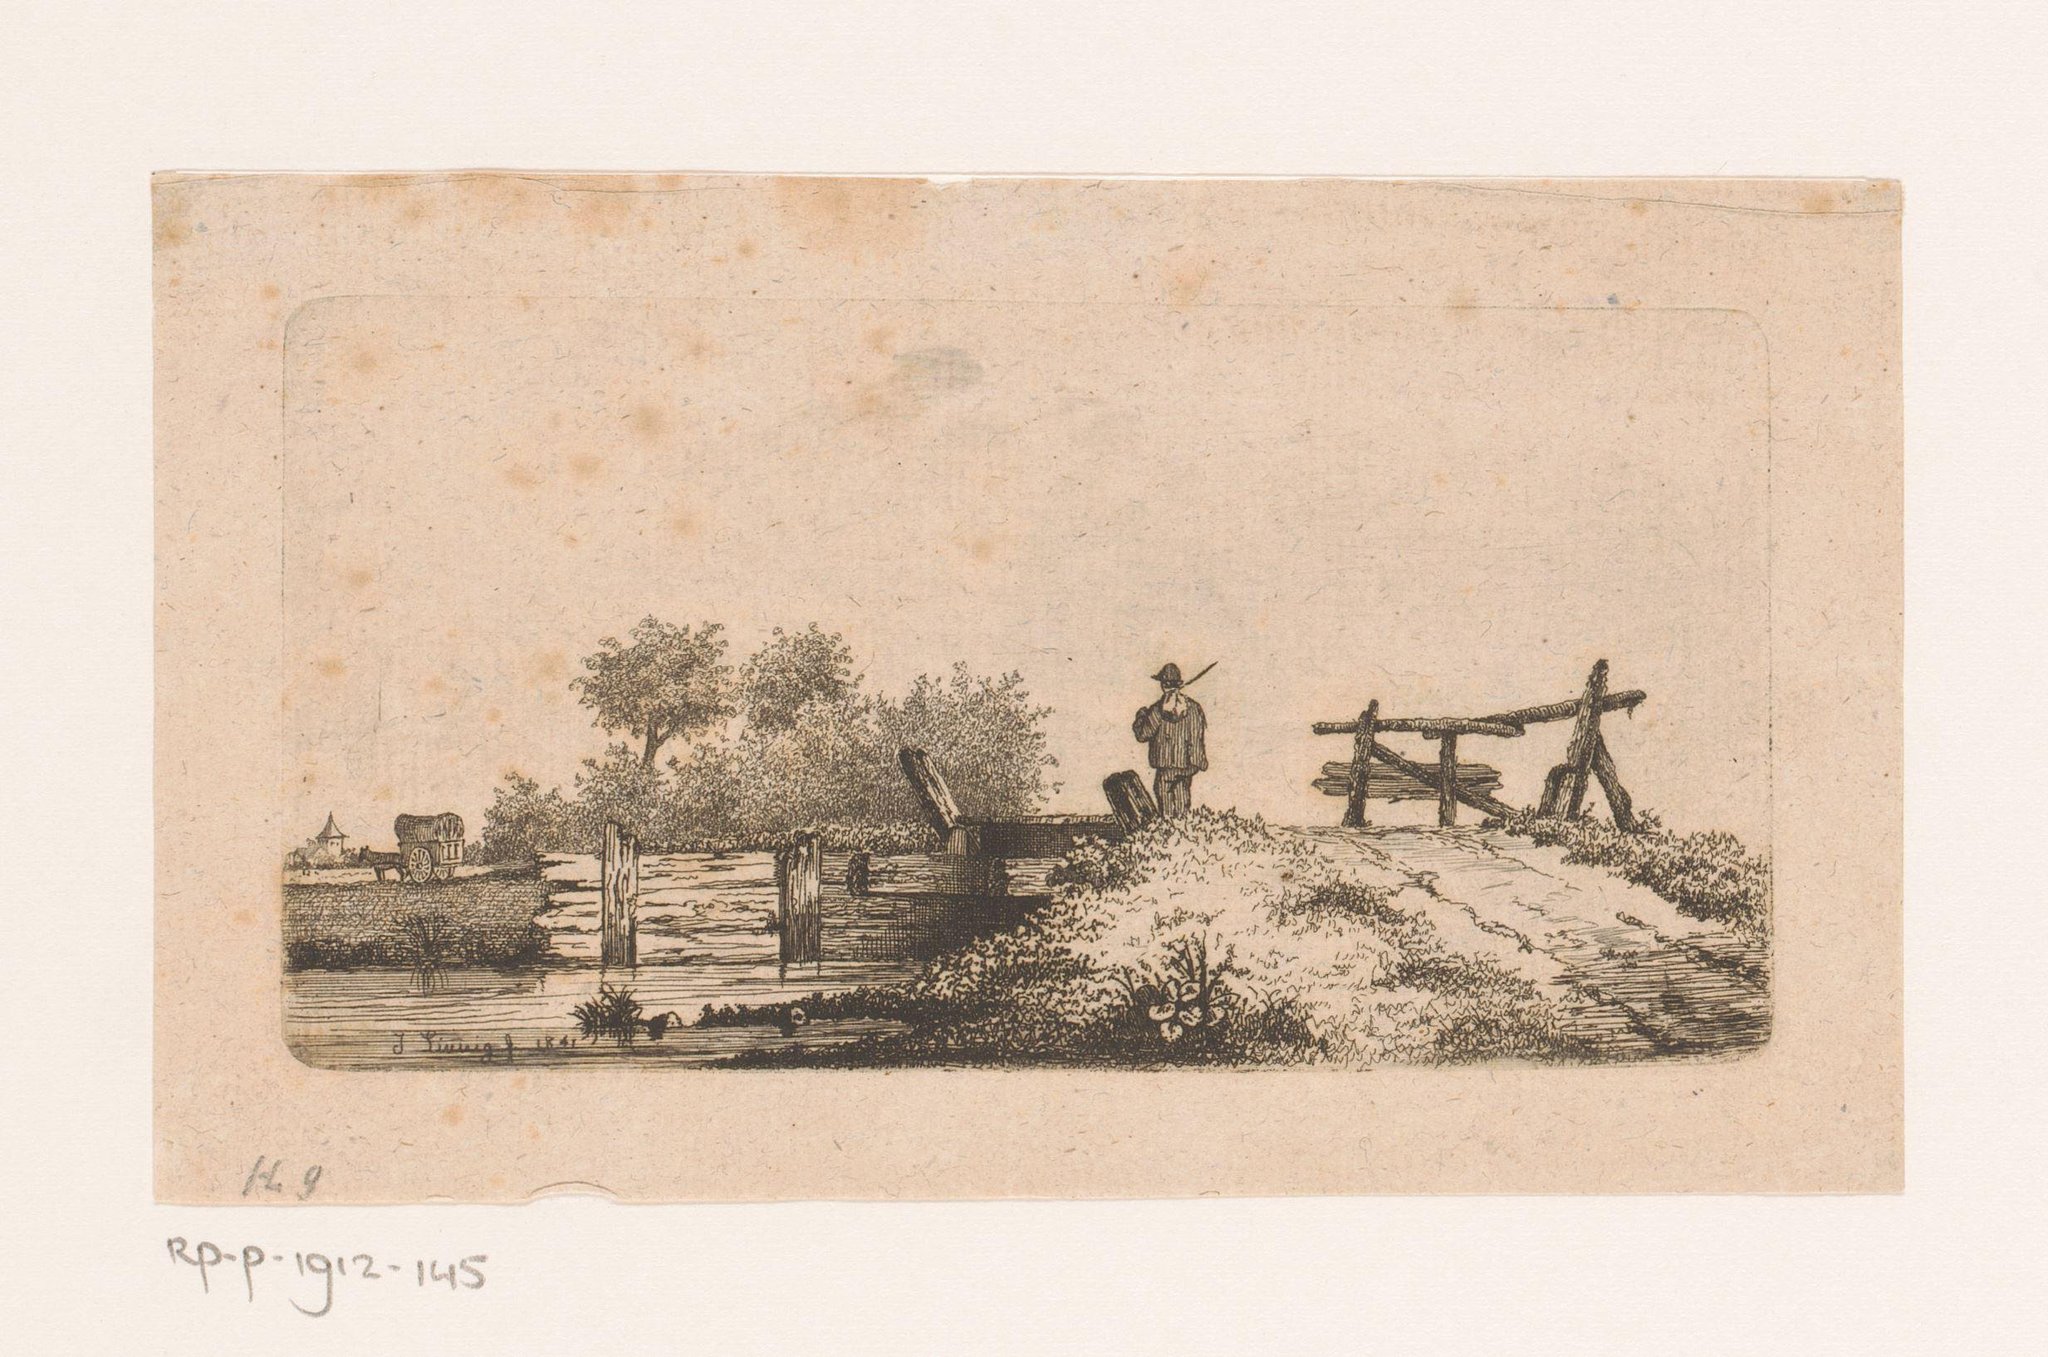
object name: print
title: Landschap met een houten brug bij Ekeren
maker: jean théodore joseph linnig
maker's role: draughtsman, print maker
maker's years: 1815-1891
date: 1841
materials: paper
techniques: etching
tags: landscape with bridge, viaduct or aqueduct, covered wagon, hooded wagon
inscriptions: collector's mark: Lugt 1485, collector's mark: Lugt 2228